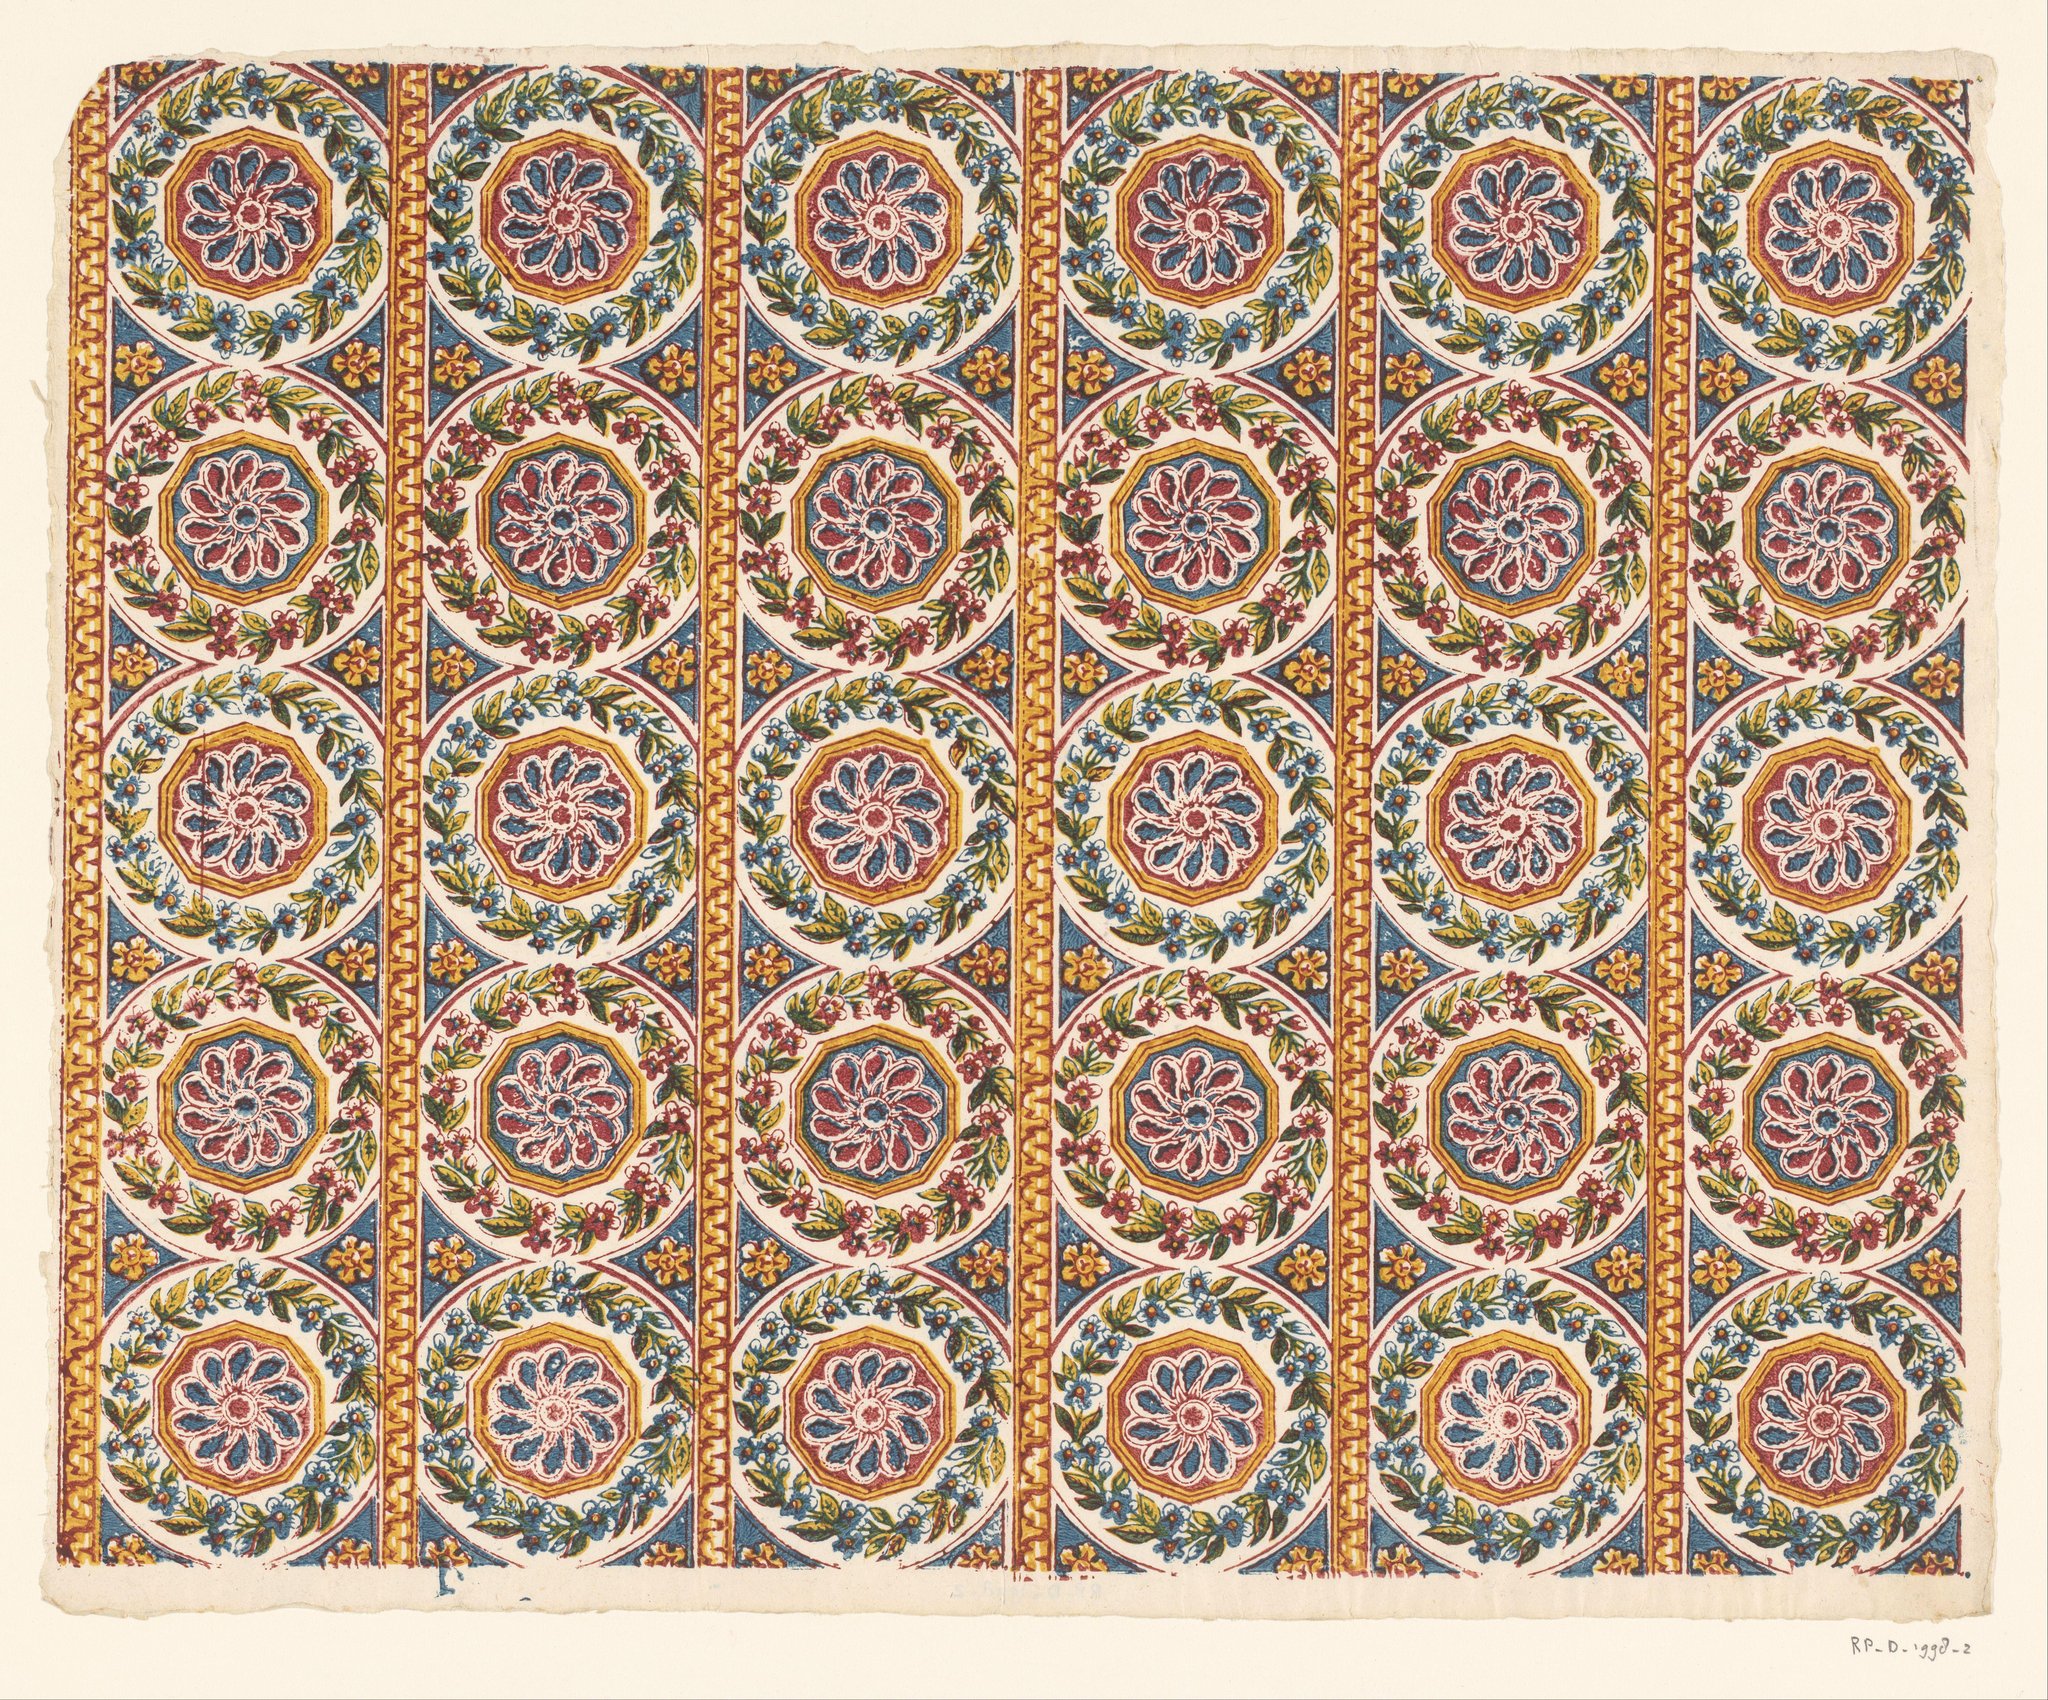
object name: printed paper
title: Blad met banenpatroon bloemornamenten en sierlijst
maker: Anonymous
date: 1750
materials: paper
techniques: printing block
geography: northern netherlands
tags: ornament derived from plant forms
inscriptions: collector's mark: Lugt 2228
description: Blad met banenpatroon van afwisselend ronde bloemornamenten met kransen en sierlijst.